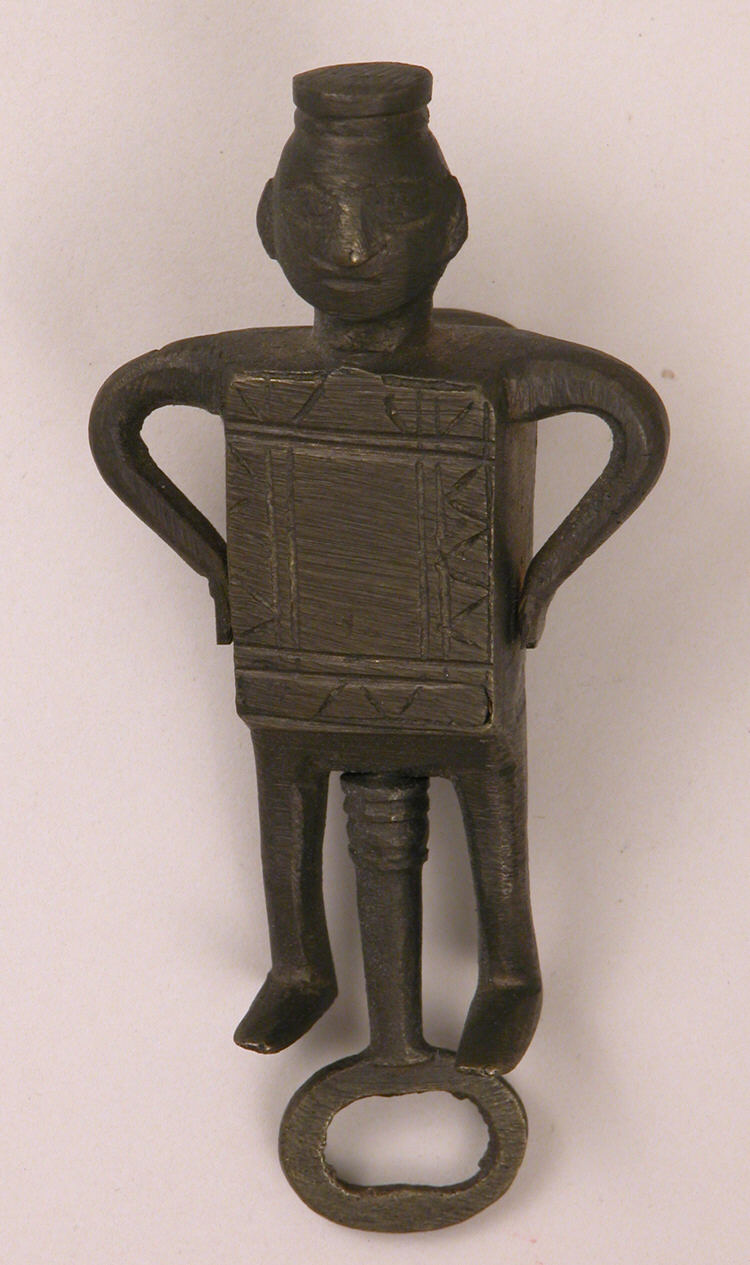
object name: padlock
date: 1701-1800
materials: brass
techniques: casting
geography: india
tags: men